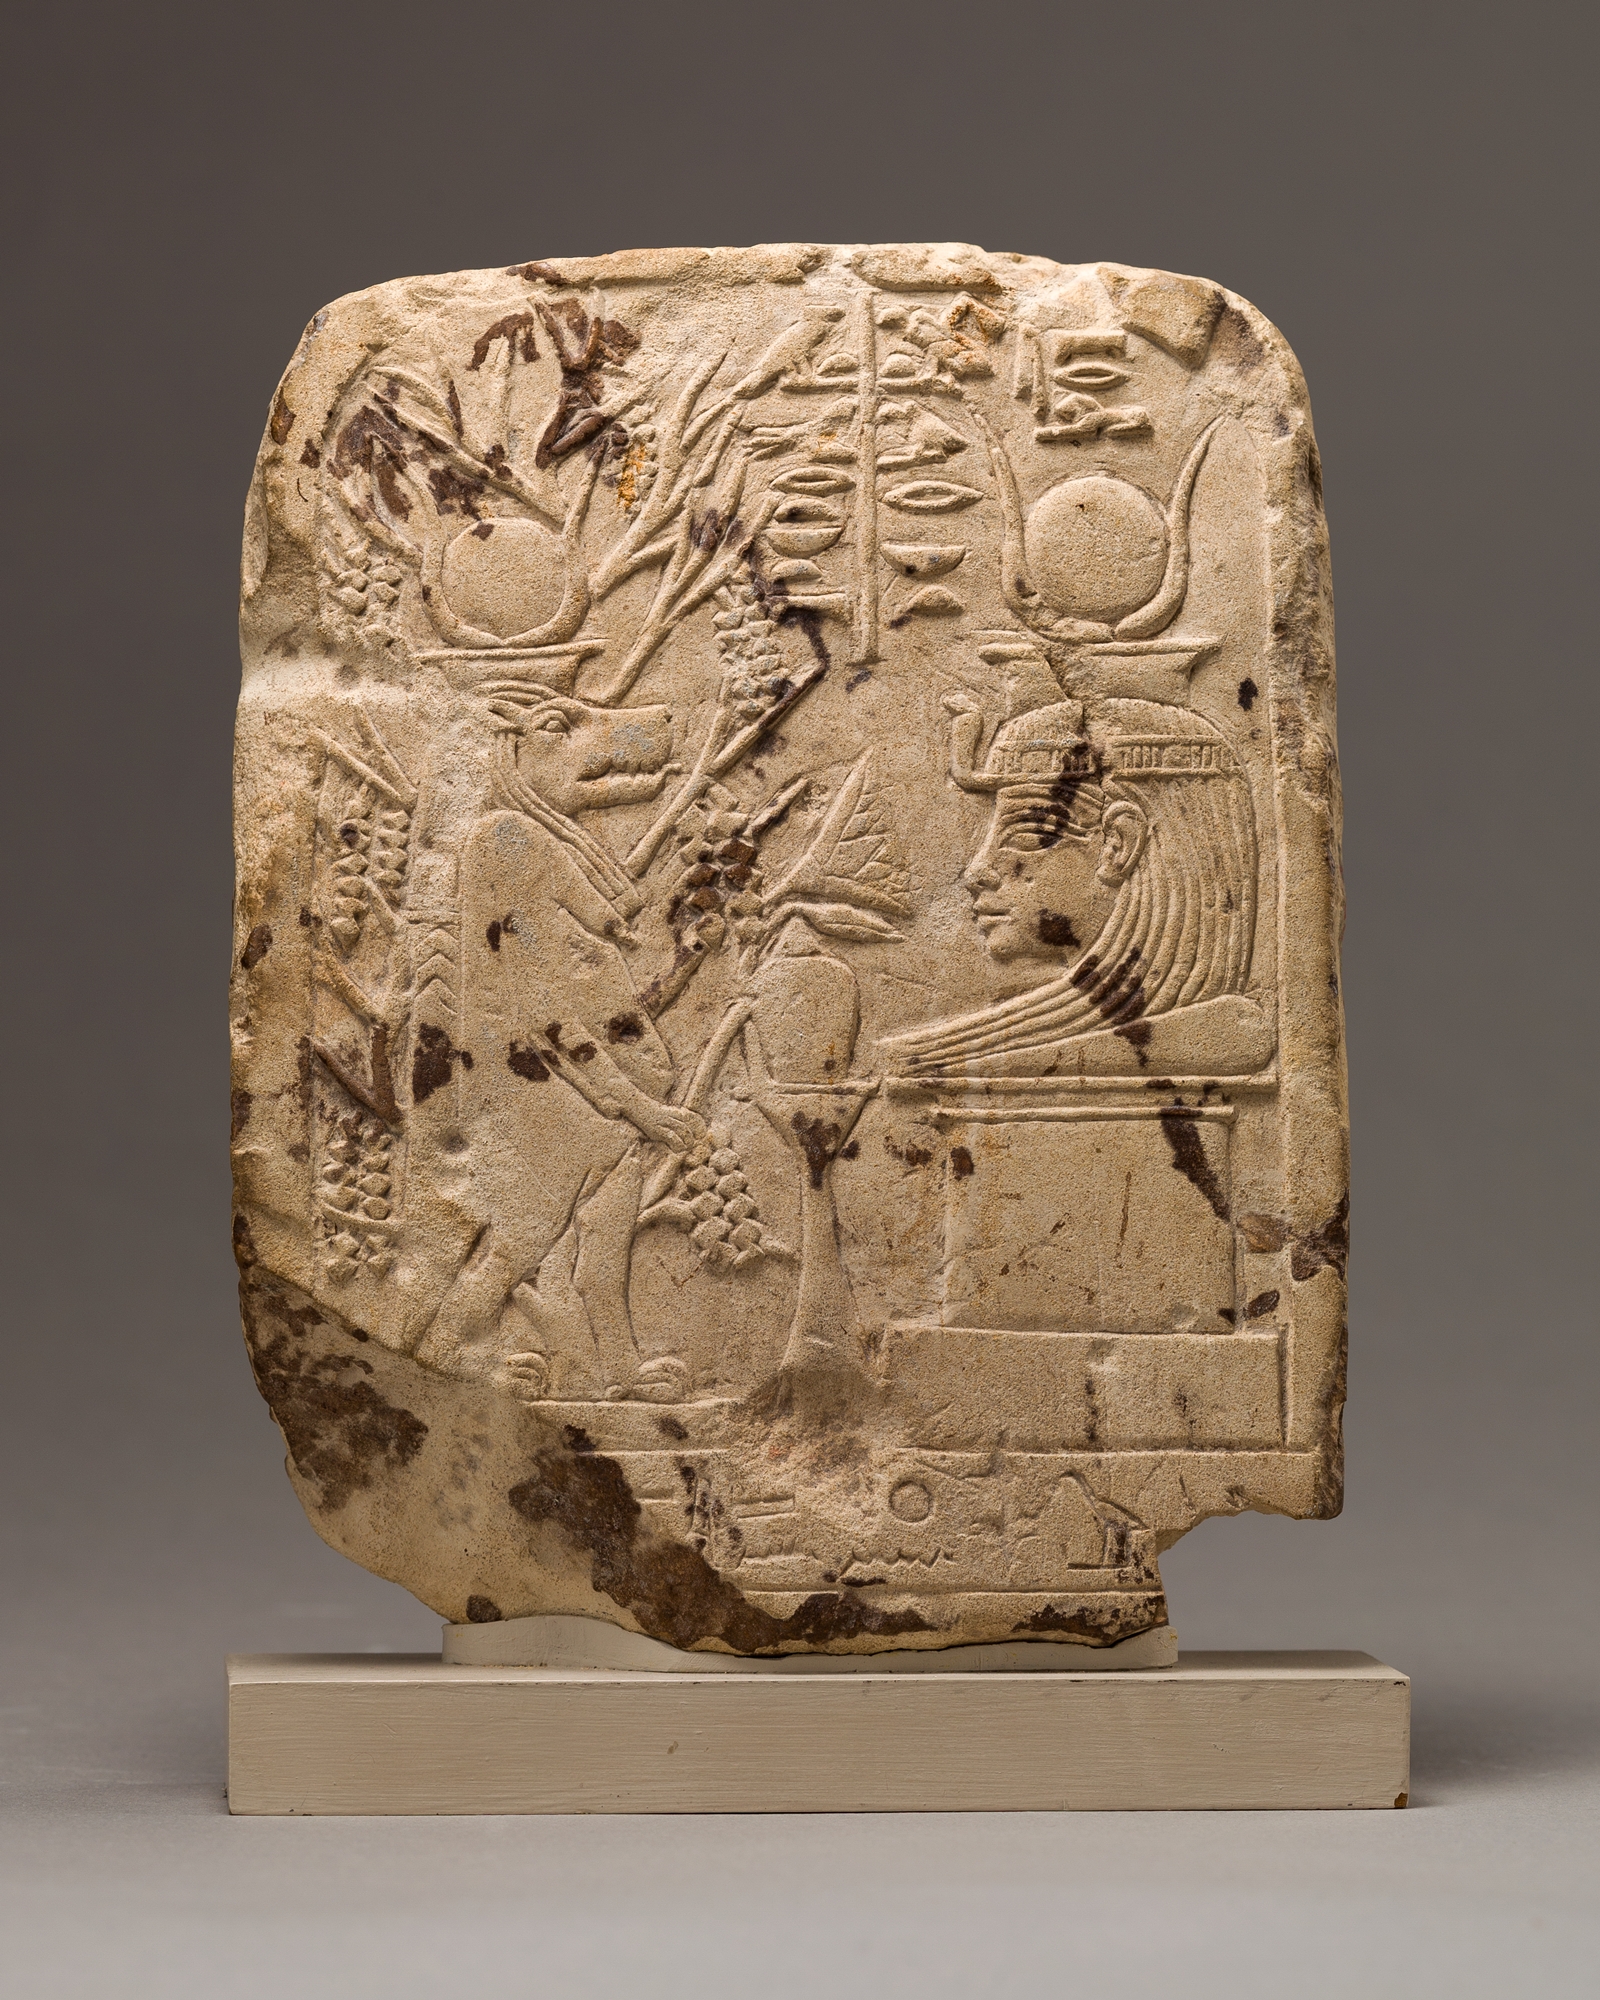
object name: stela, taweret, mut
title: Stela with Taweret and Mut of Isheru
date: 1390-1352 BCE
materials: limestone, paint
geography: upper egypt, thebes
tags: hieroglyphs,hathor,taweret,goddess